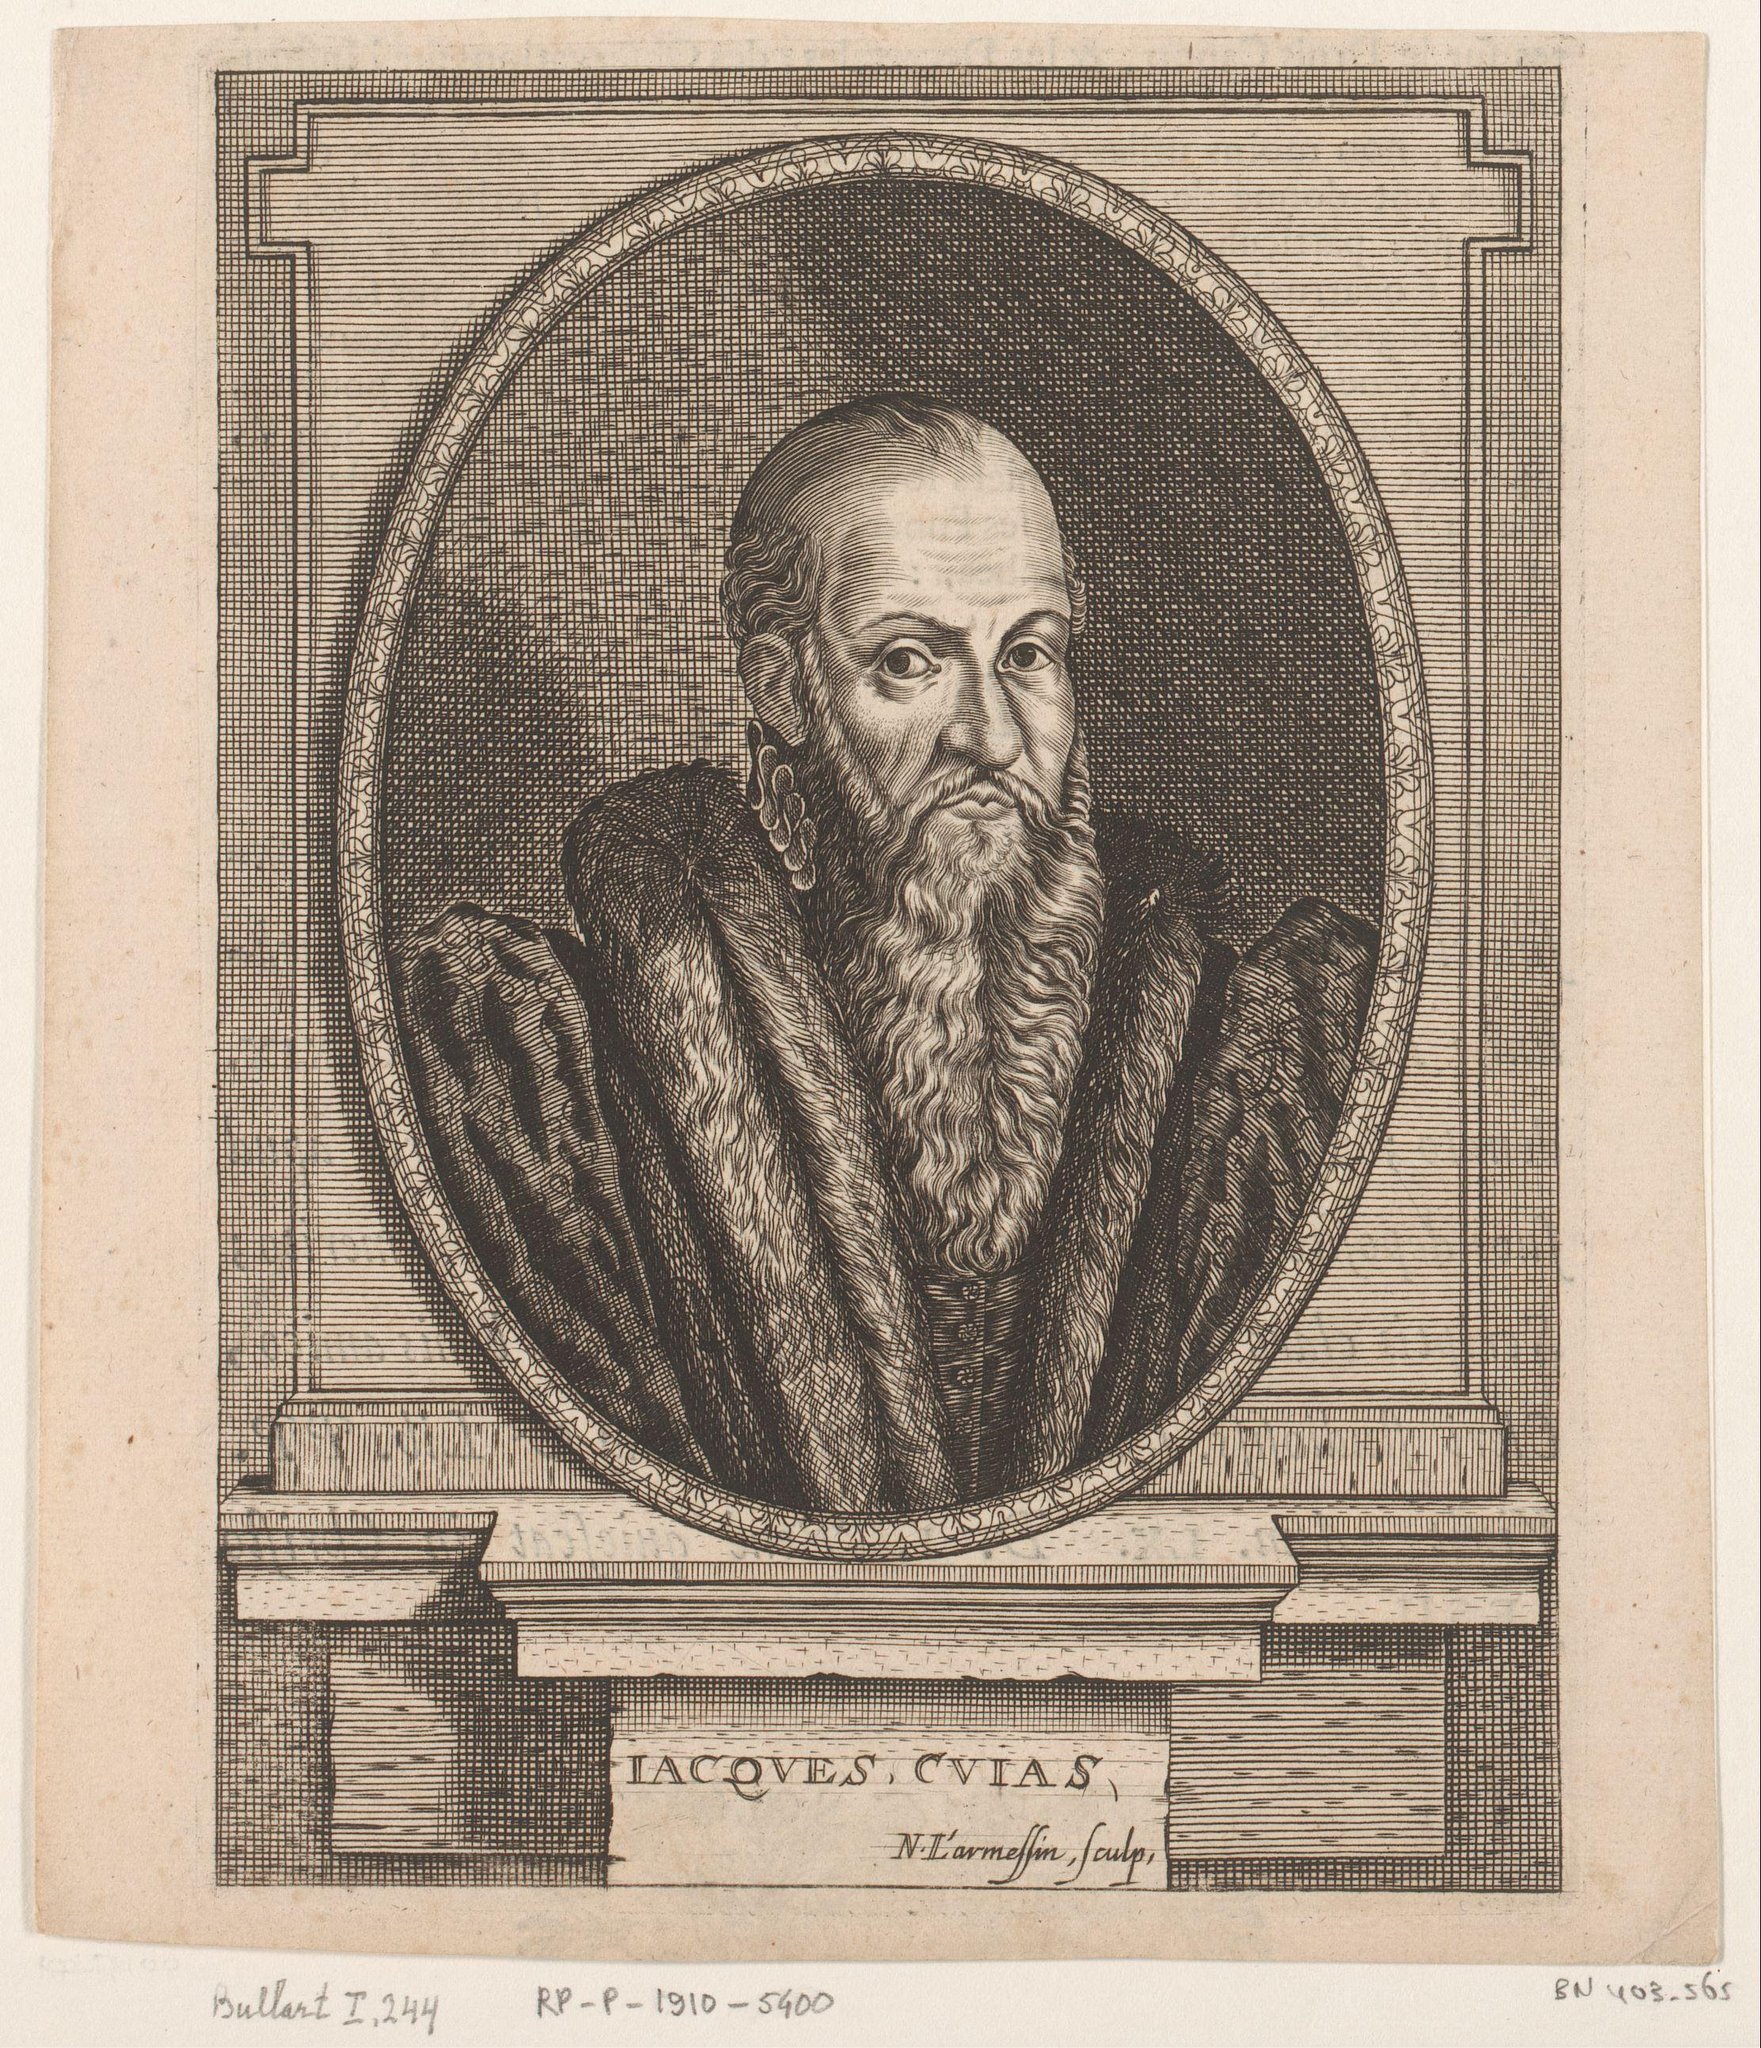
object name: book illustration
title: Portret van Jacques Cujas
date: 1682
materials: paper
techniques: engraving, letterpress printing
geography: brussels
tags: historical persons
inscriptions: collector's mark: Lugt 2228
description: Prent gebruikt voor: Bullart, Isaac. Académie des Sciences et Arts contenant les vies et éloges his. des hommes illustres qui ont excellé en ces professions depuis environ quatre siècles. Brussel: François Foppens, 1682. Het boek werd in 1682 eveneens in Amsterdam uitgegeven door de erfgenamen van Daniel Elzevier. Ieder portret betreft een illustratie bij de biografie van een kunstenaar of geleerde. De meeste portretten werden door Nicolas de Larmessin vervaardigd (162), 93 door De Boulonois en een derde door ongeïdentificeerde prentmakers. Dit betreft een illustratie op p. 244, deel I.